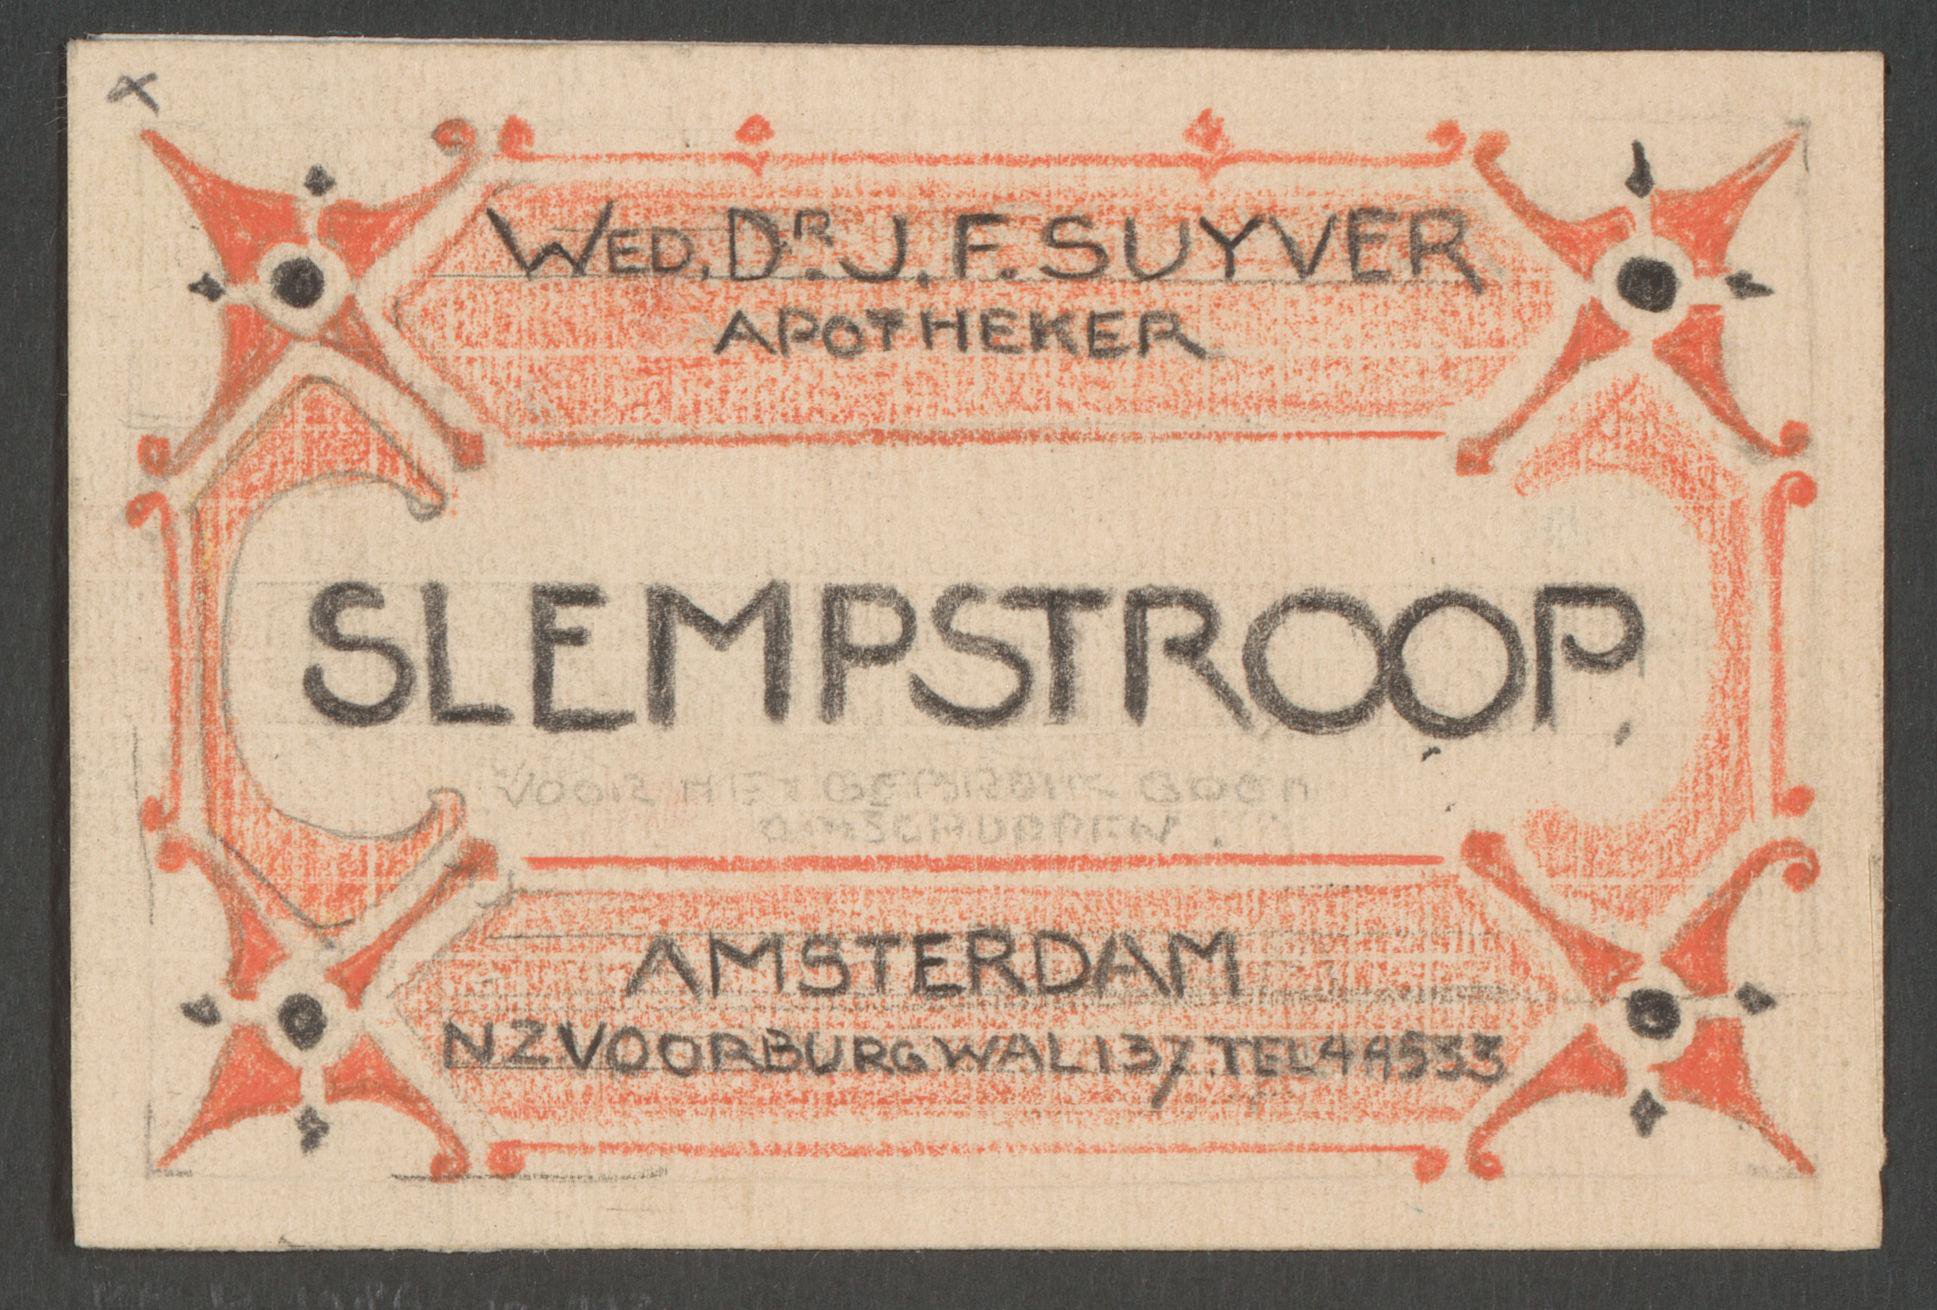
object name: drawing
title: Ontwerp voor een apothekersetiket voor slemstroop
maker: reinier willem petrus de vries (1874-1953)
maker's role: draughtsman, print maker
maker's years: 1874-1953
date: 1931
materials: chalk, paper, pencil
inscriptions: collector's mark: ‘R:MVS.’, annotation